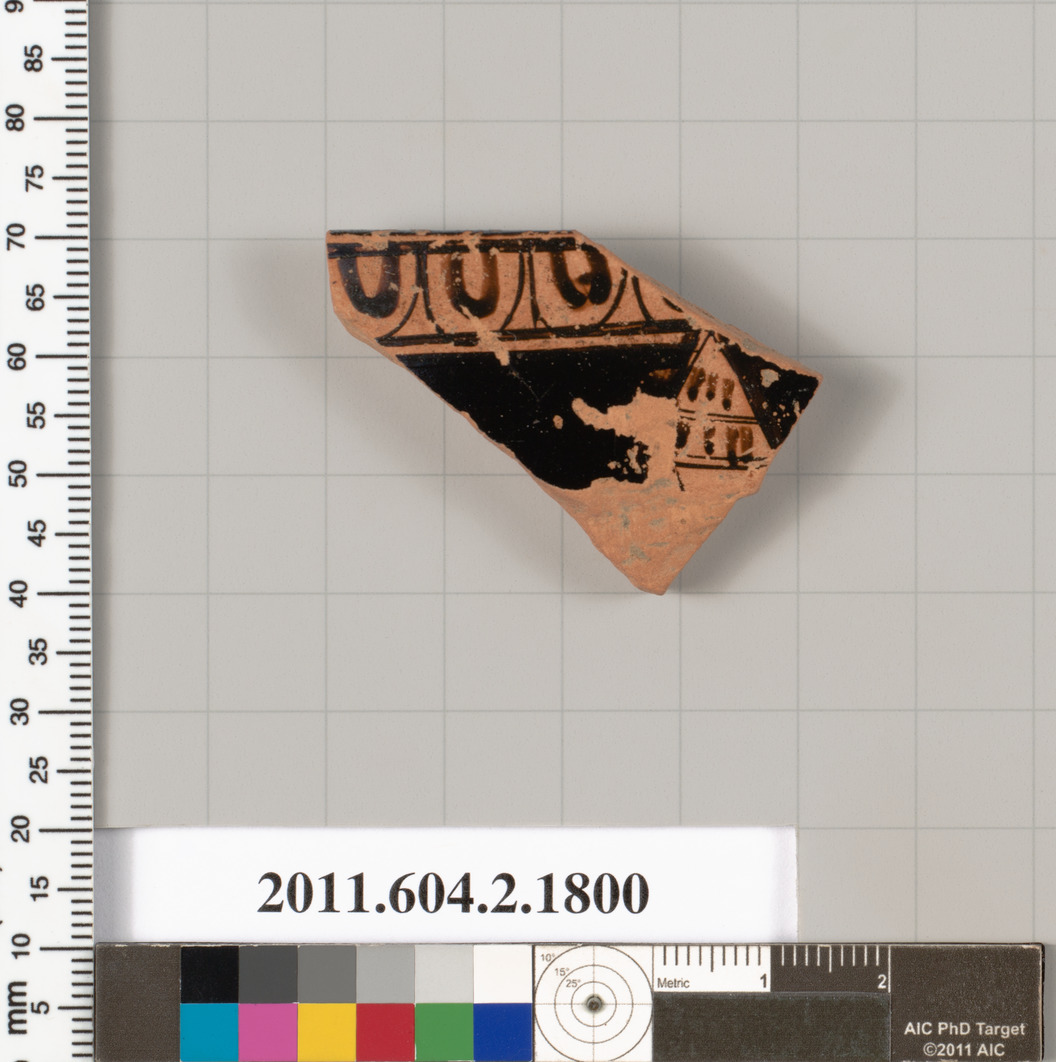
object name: skyphos fragment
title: Terracotta rim fragment of a skyphos (deep drinking cup)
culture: greek, attic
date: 434-368 BCE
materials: terracotta